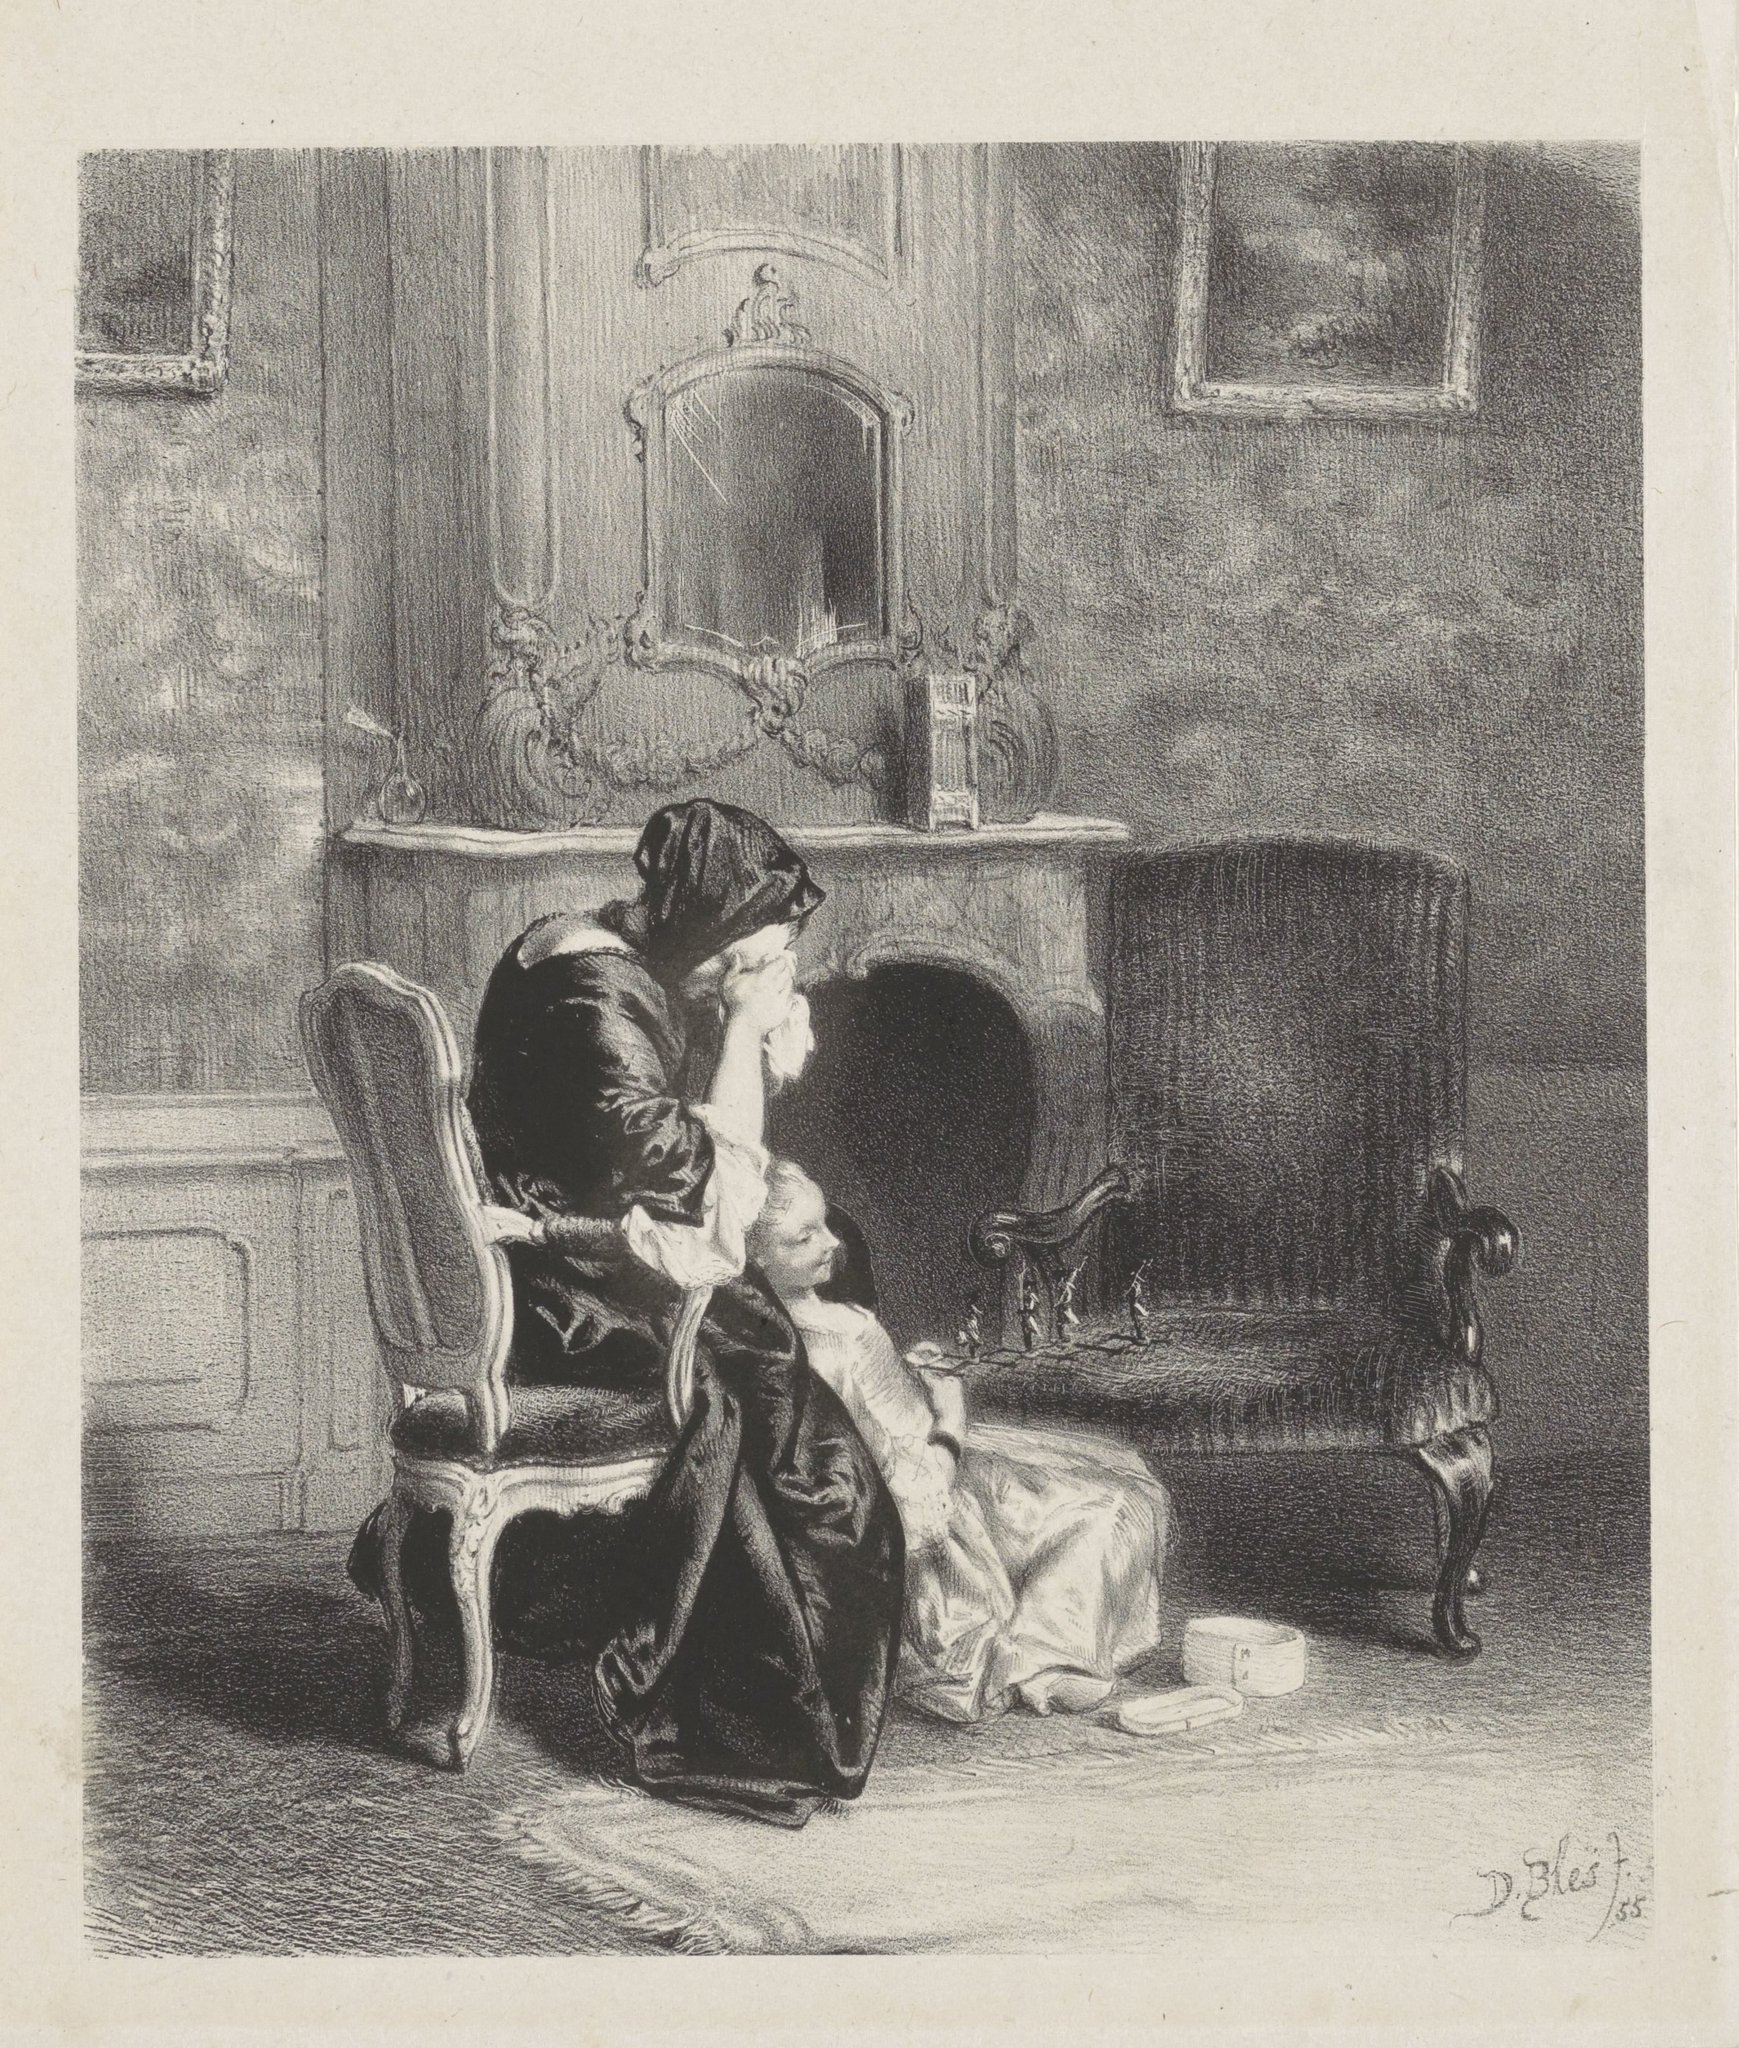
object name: print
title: Huilende vrouw in interieur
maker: david bles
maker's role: draughtsman, painter, print maker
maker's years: 1821-1899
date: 1855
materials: paper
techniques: lithograph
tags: weeping, mother and baby or young child, (playing with) toys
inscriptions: collector's mark: Lugt 2228, collector's mark: Lugt 2227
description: Tegenover de vrouw staat een lege stoel. Een meisje zit op de grond tegen de benen van de vrouw aangeleunt. Ze speelt met soldaatjes.